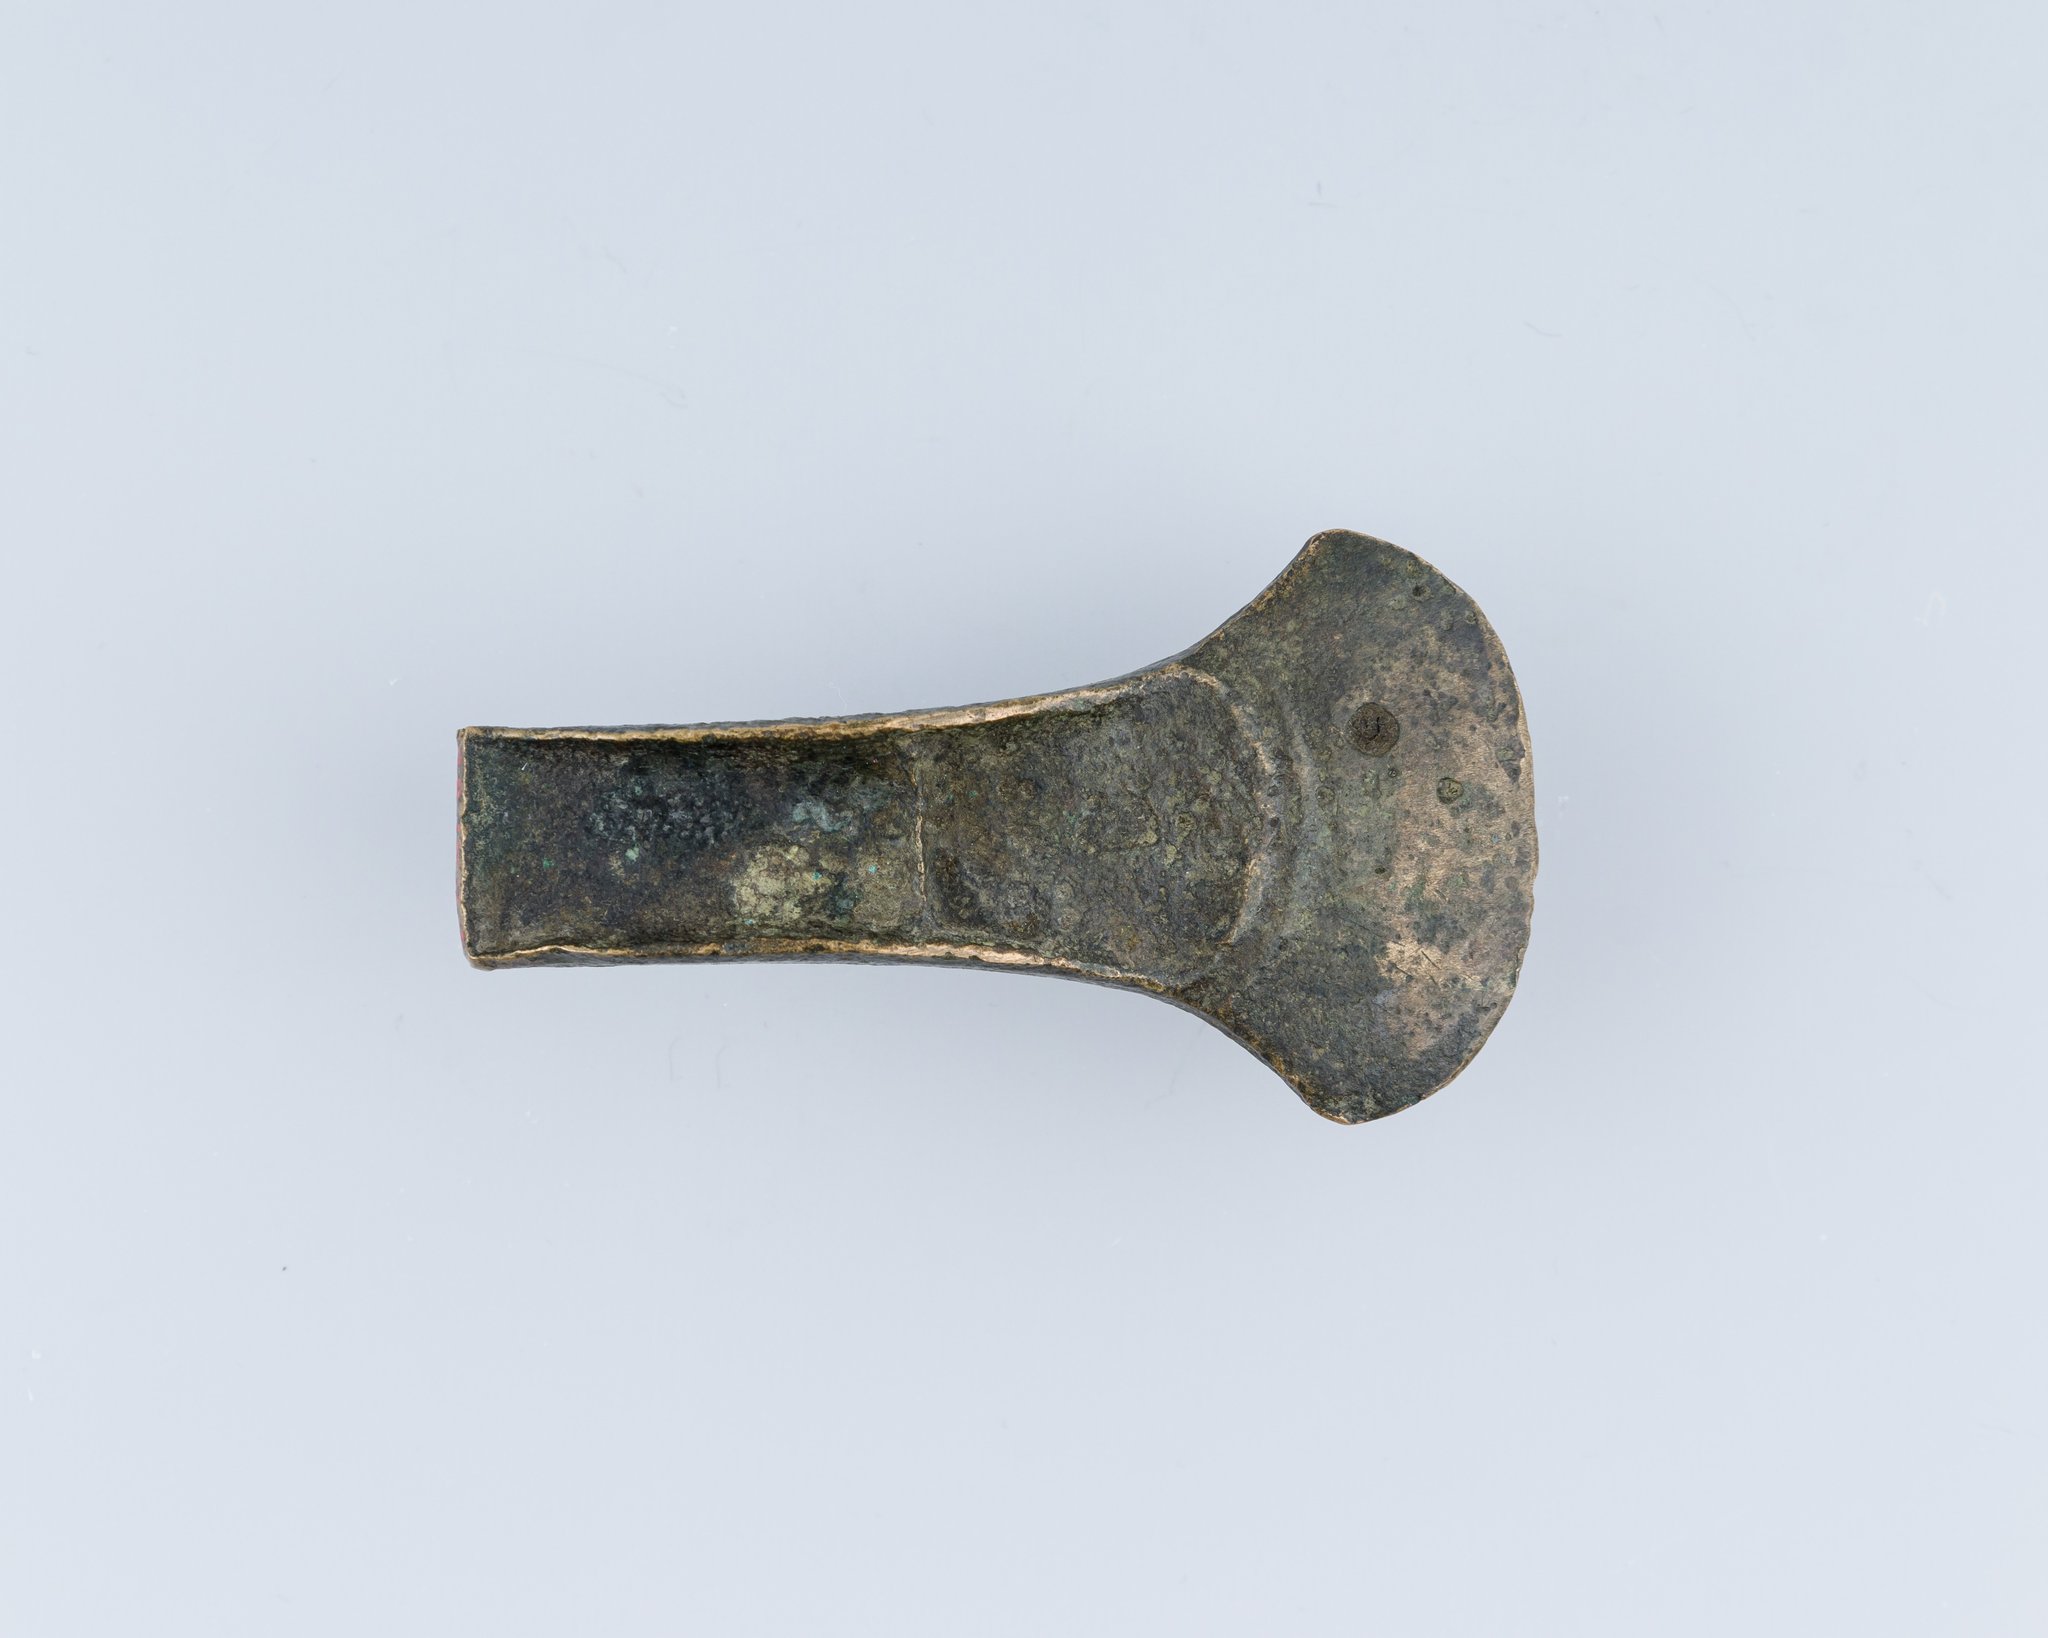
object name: ax of the palstave type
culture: irish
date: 1500-1200 BCE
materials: bronze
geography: ireland